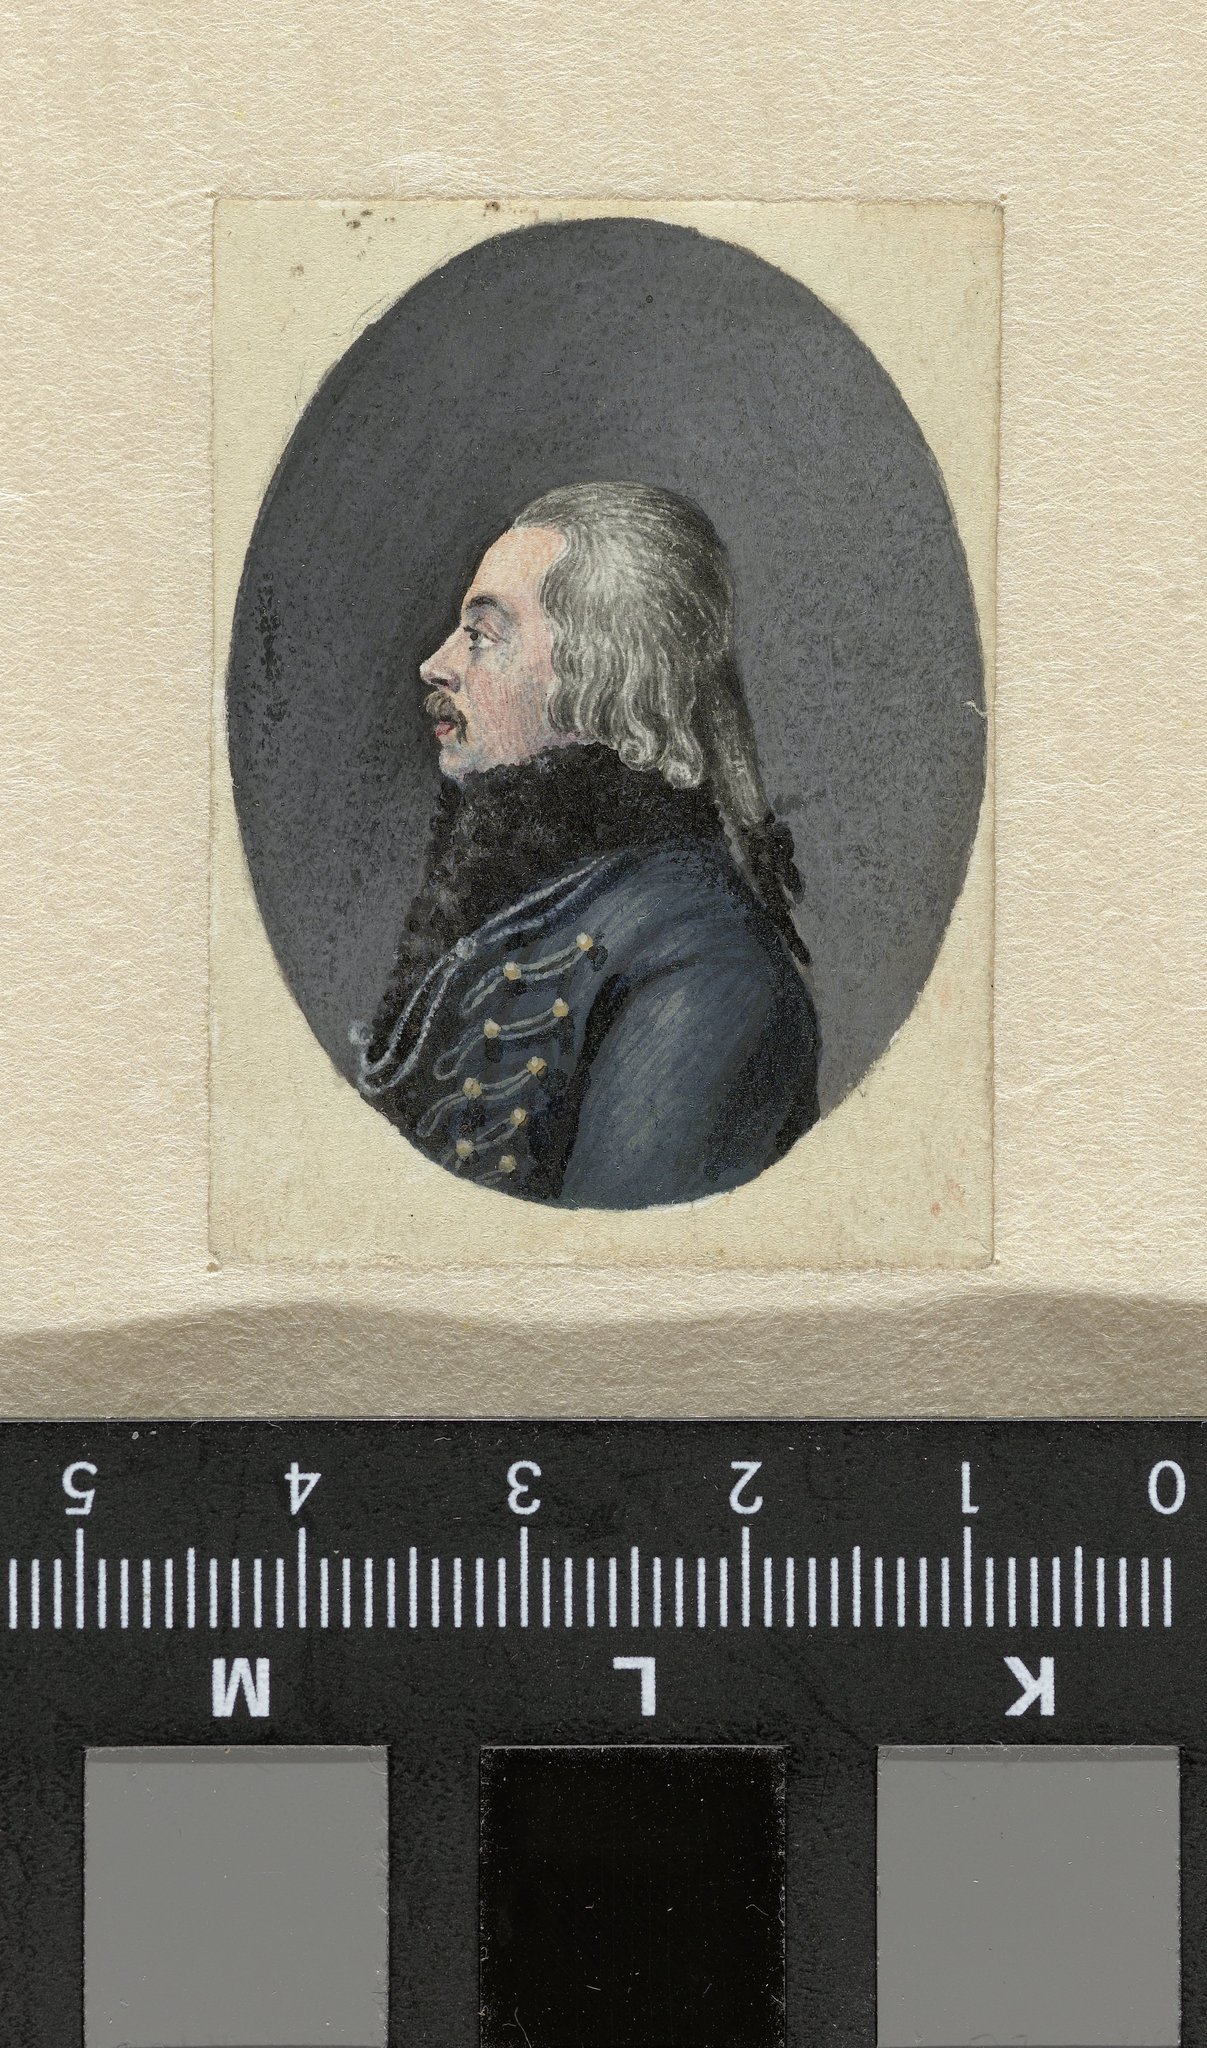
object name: drawing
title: Portret van een huzarenofficier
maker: ernst willem jan bagelaar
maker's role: draughtsman, print maker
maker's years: 1775-1837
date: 1785-1837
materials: ink, paper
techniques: brush, pen